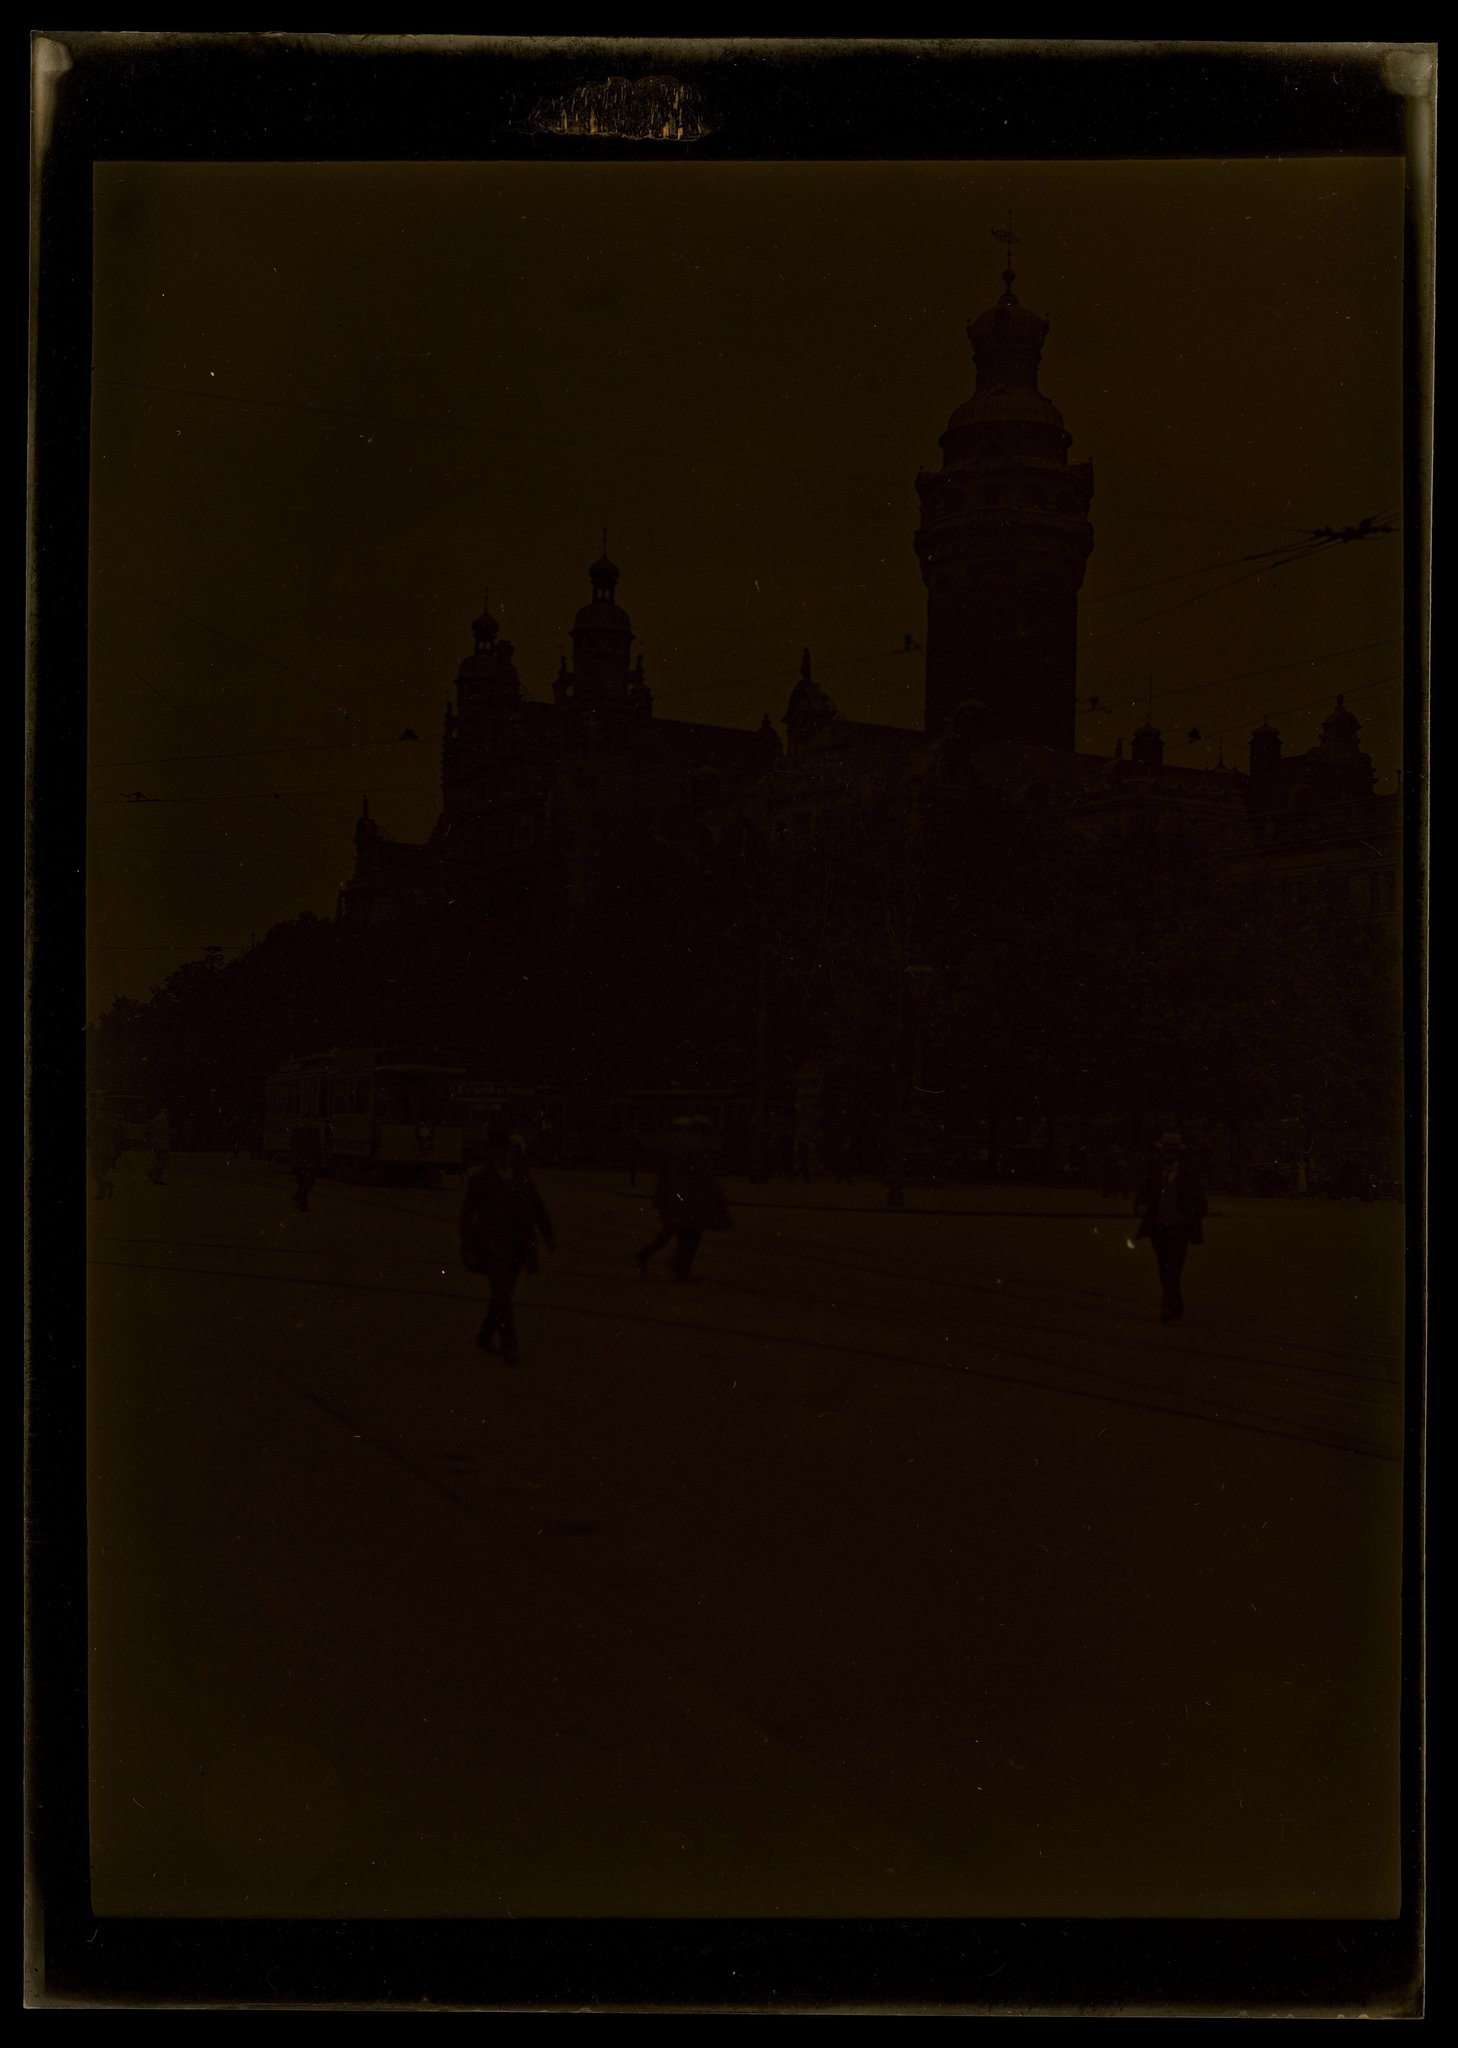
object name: photograph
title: Filmnegatief met opname van Leipzig en huis te Bünde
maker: Anonymous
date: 1921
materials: film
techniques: gelatin silver negative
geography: germany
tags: germany